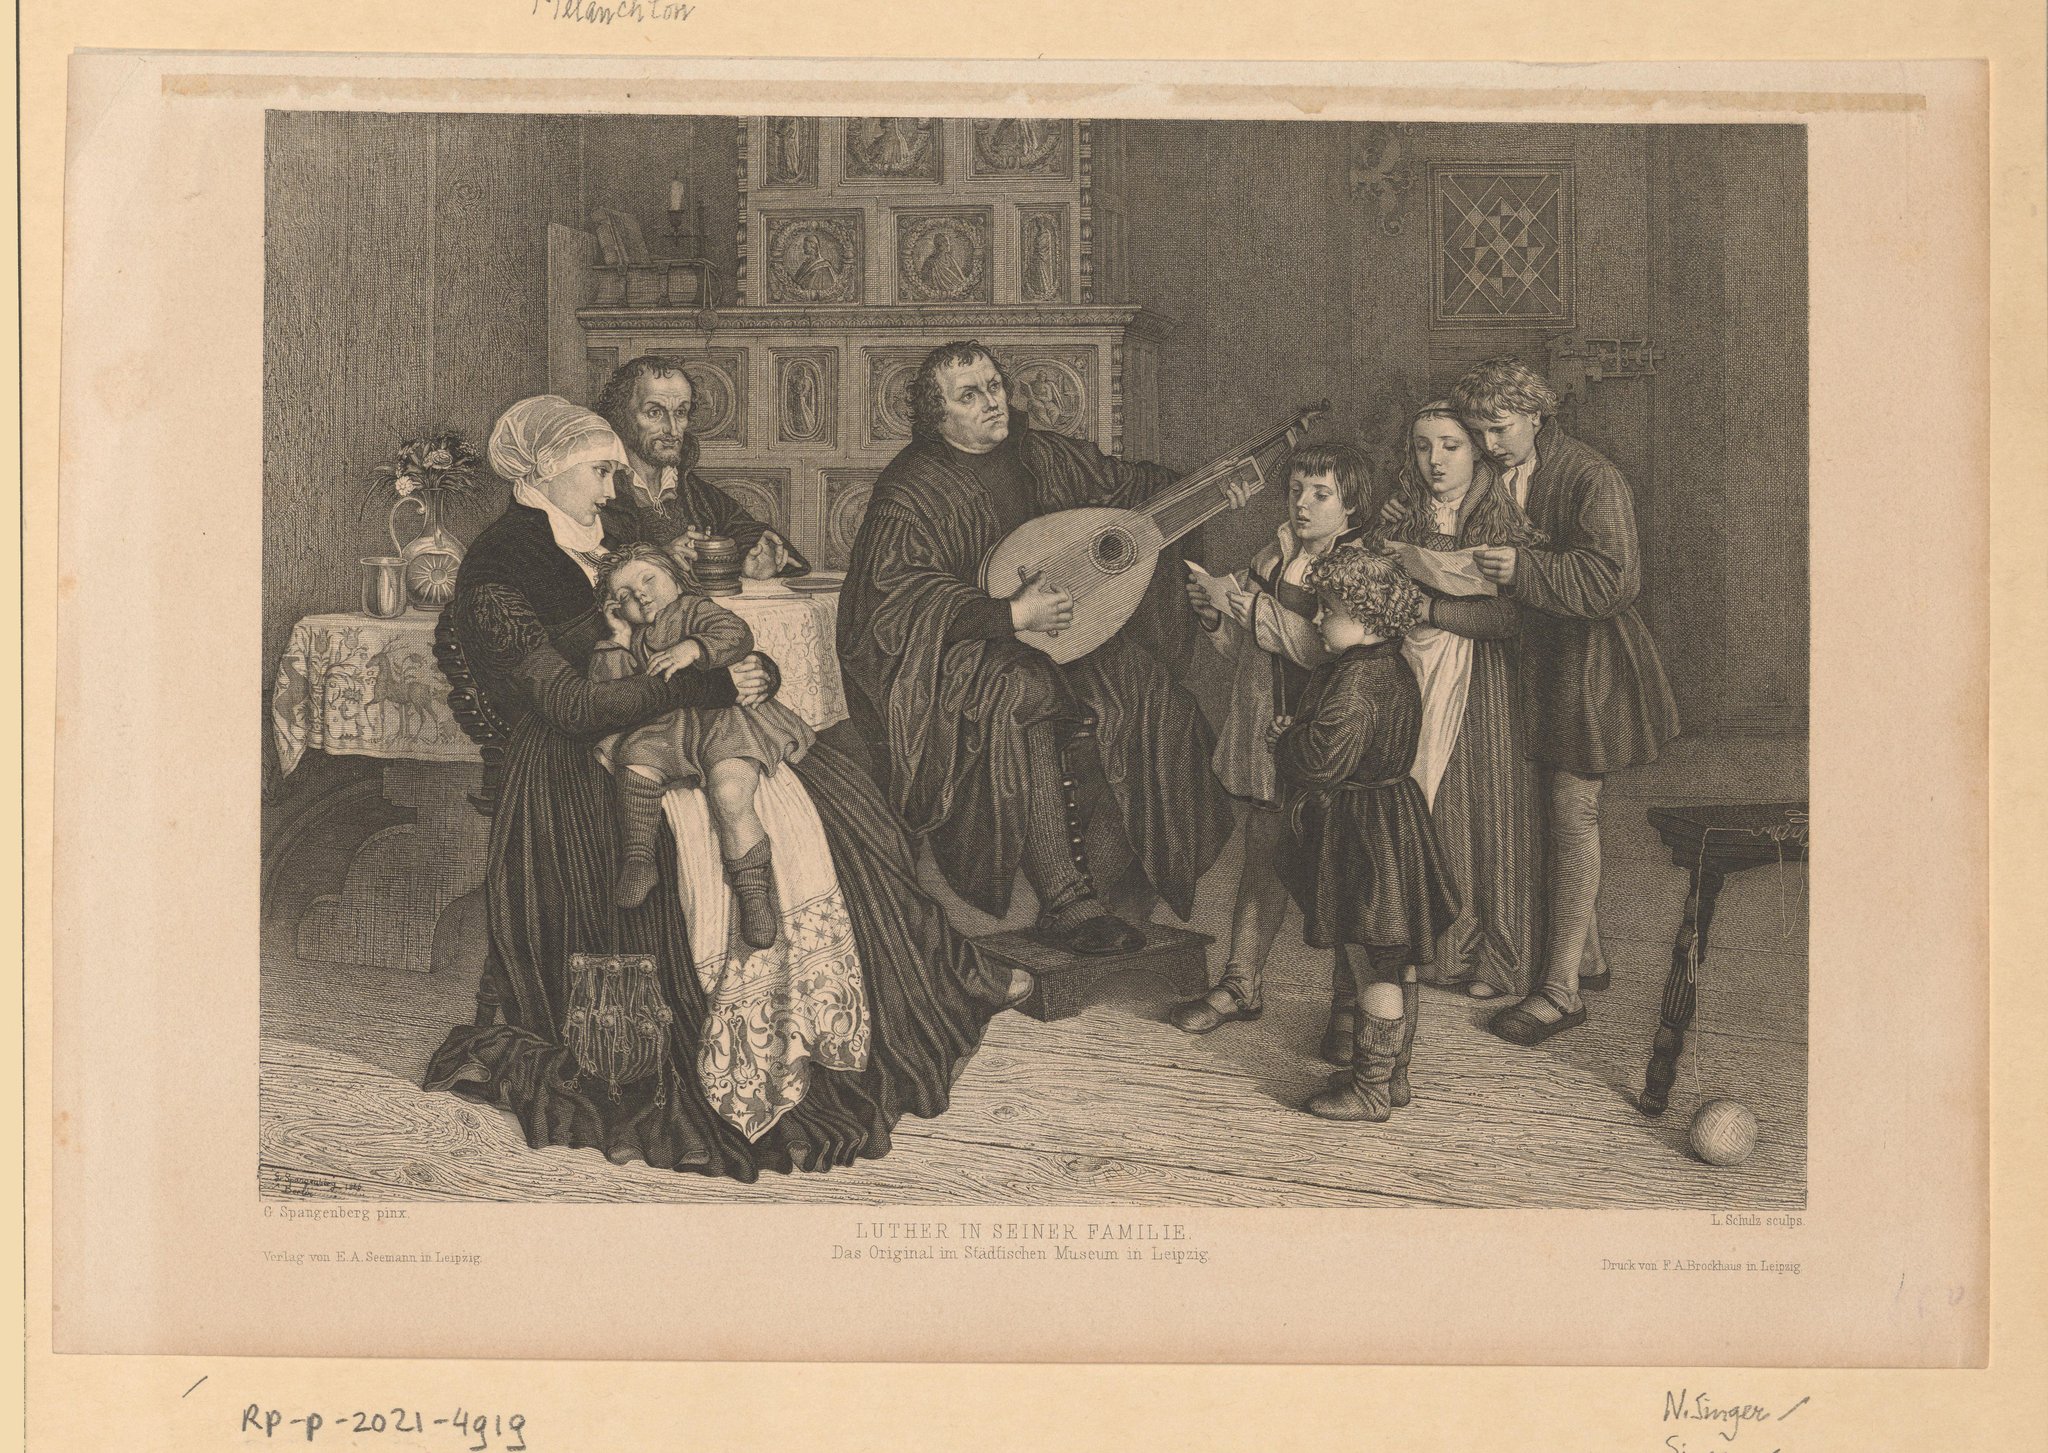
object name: print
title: Luther in seiner Familie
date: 1877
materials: paper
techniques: engraving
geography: leipzig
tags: priest, martin luther, instrumental and vocal music together, parents with their children, theologian, historical persons - bb - woman, historical persons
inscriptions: collector's mark: Lugt 2228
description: Prent waarschijnlijk uit: Zeitschrift für bildende Kunst 12 (1877).